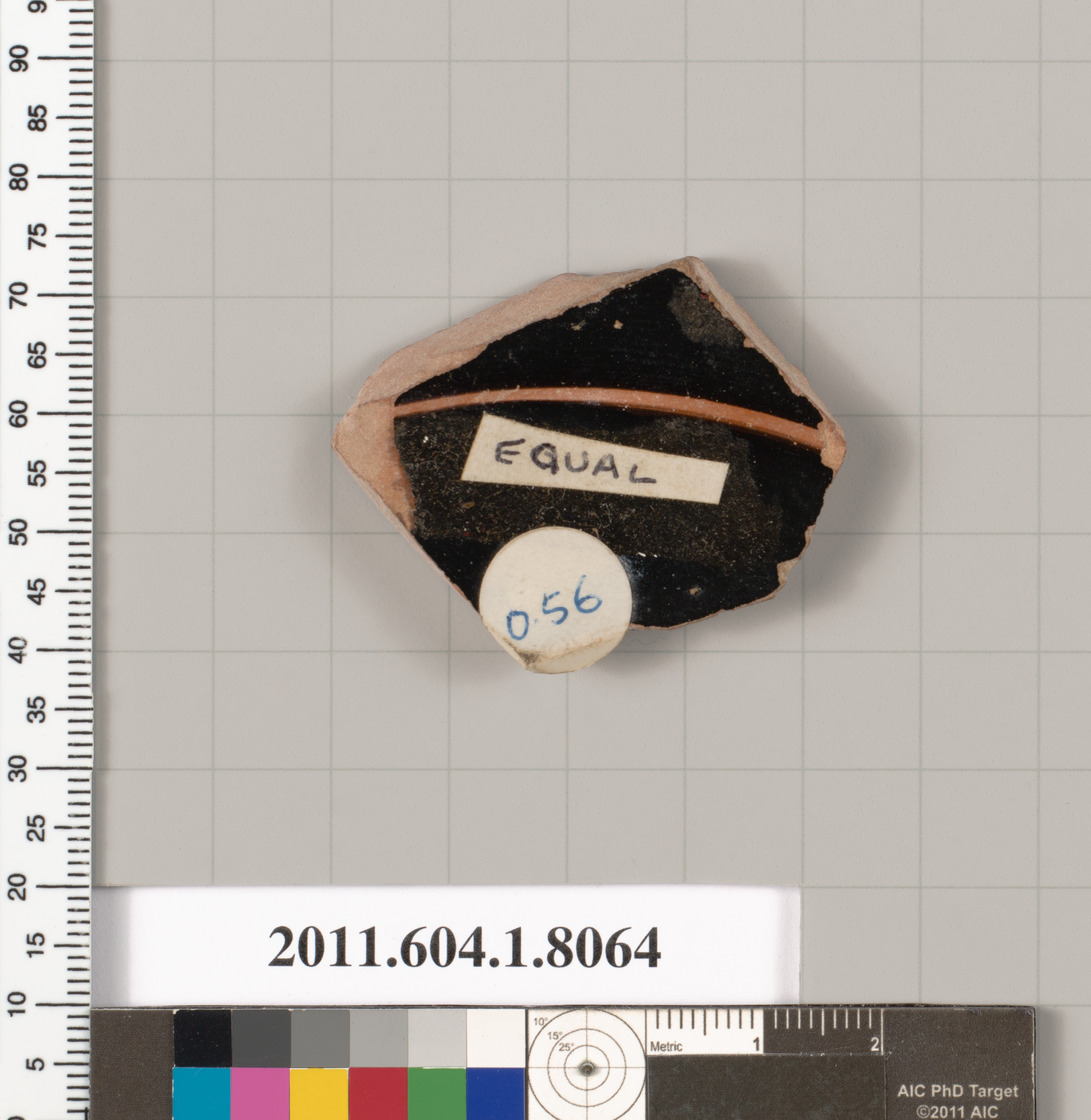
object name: kylix fragment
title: Terracotta fragment of a kylix (drinking cup)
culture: greek, attic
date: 510-500 BCE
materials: terracotta